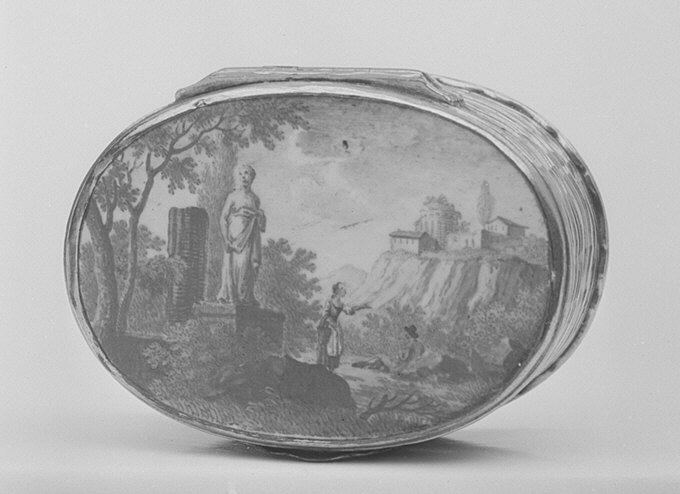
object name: box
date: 1751-1775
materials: gilt copper, porcelain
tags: human figures,landscapes